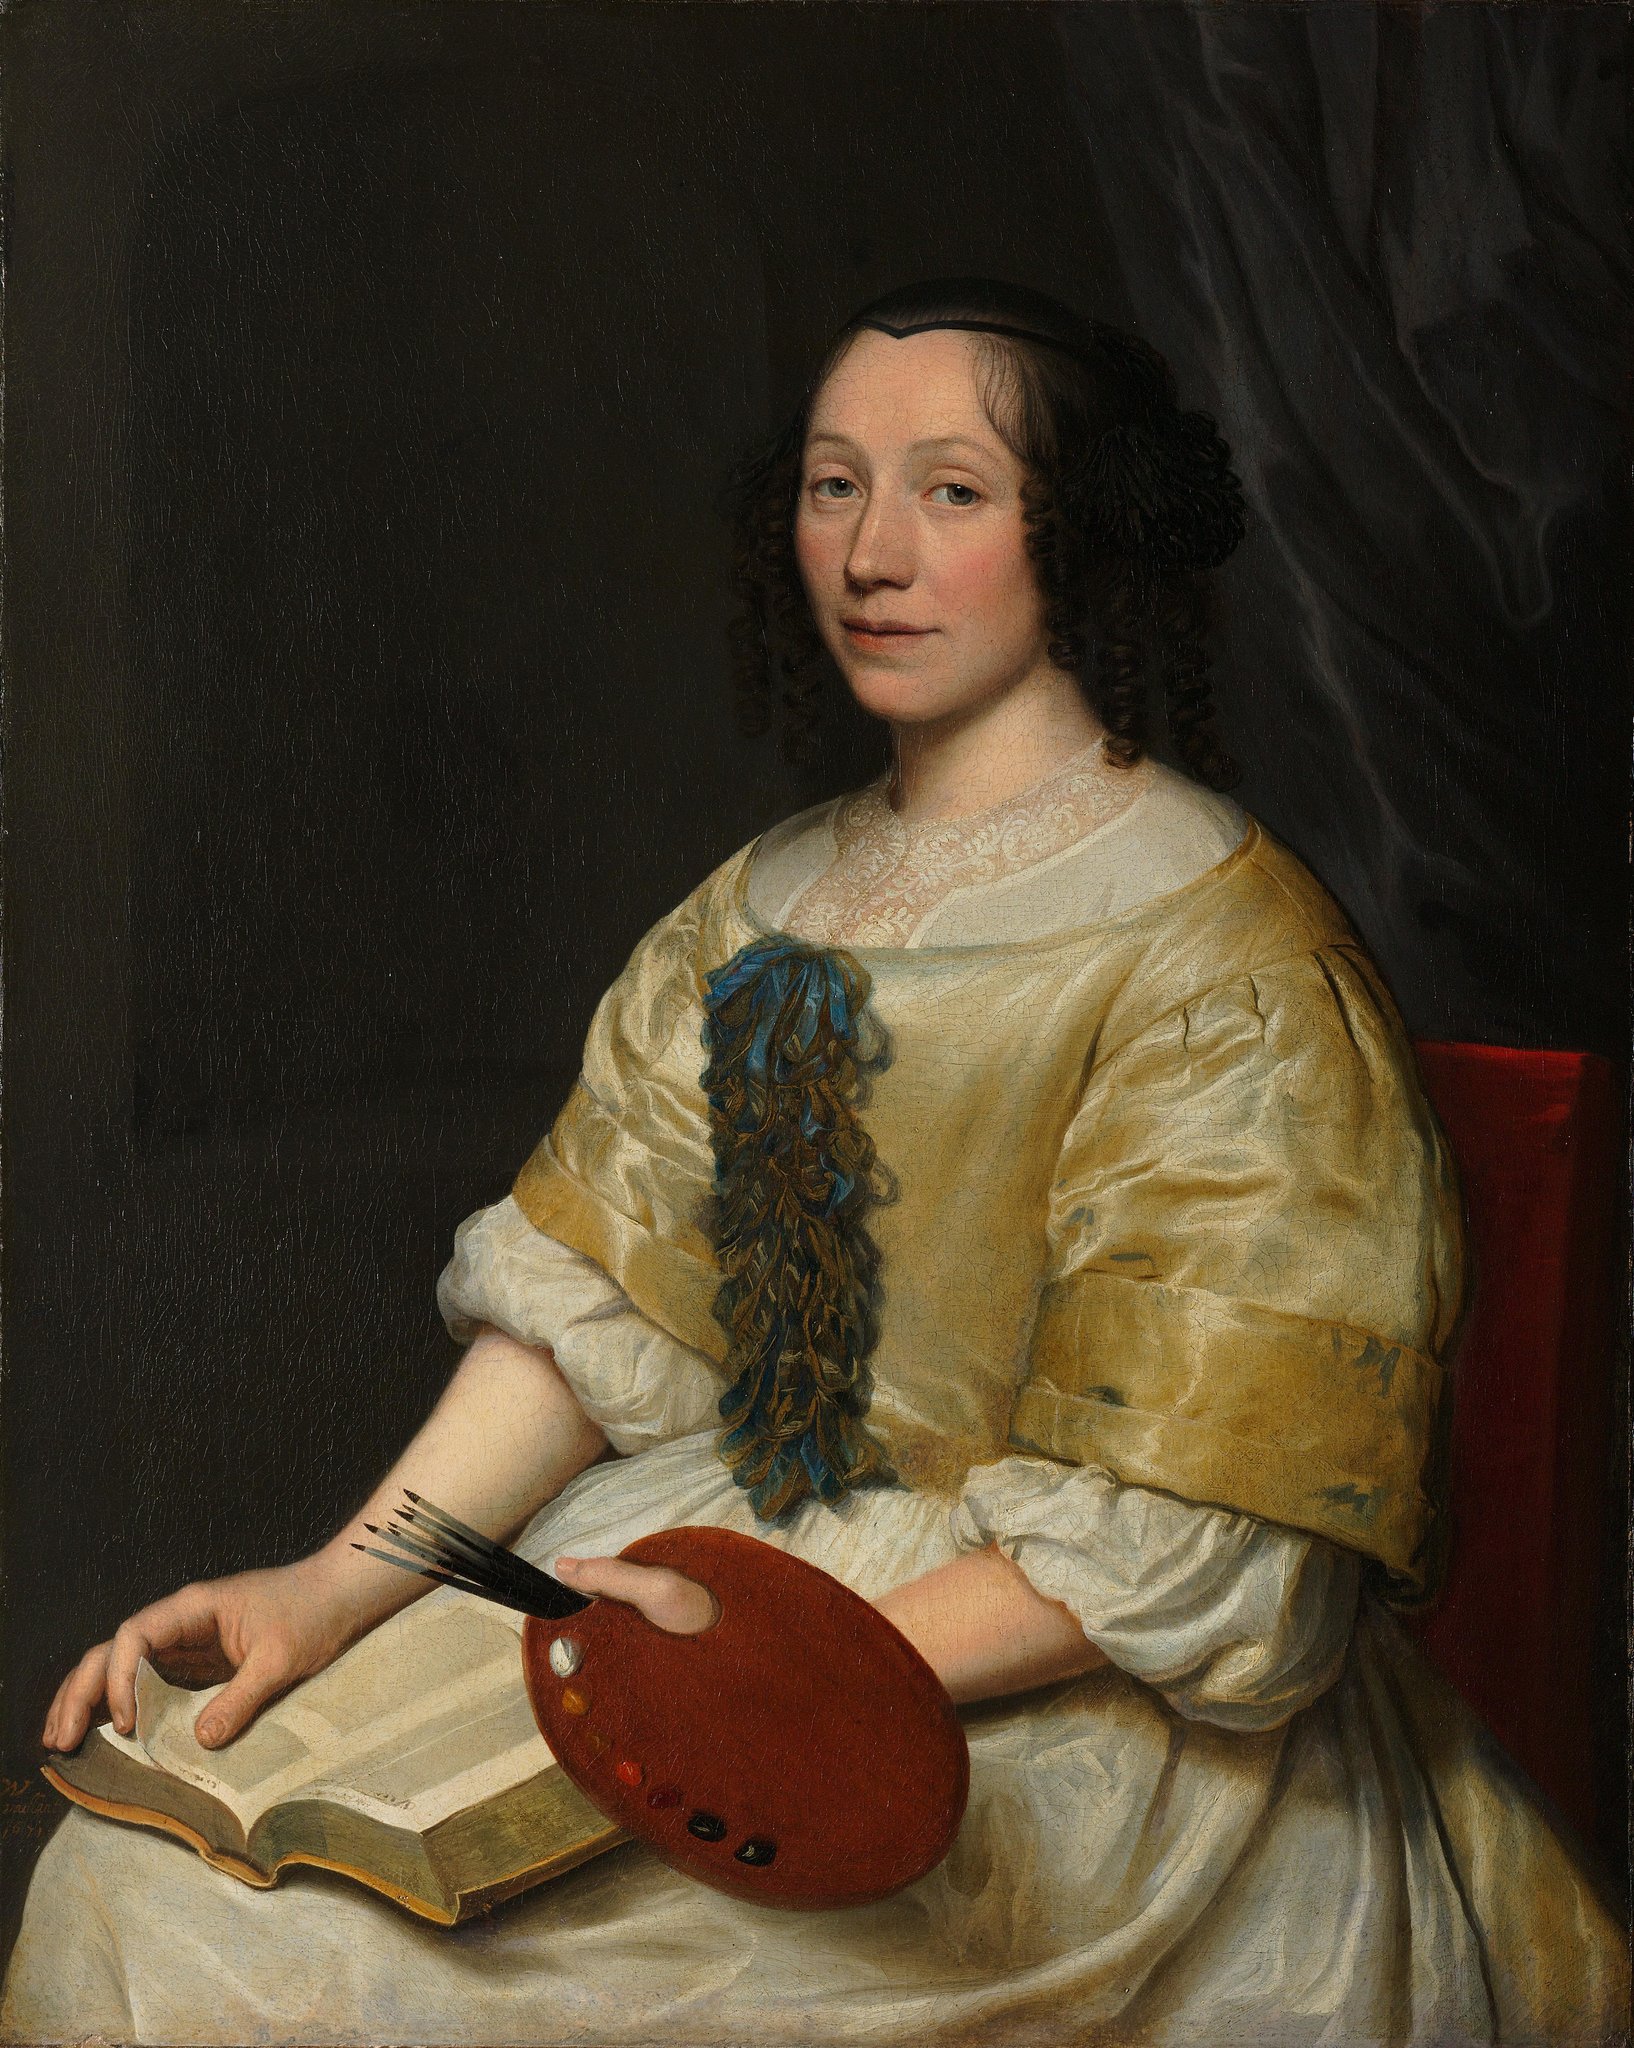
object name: painting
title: Portrait of Maria van Oosterwijck (1630-1693)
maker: wallerant vaillant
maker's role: draughtsman, painter, print maker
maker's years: 1623-1677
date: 1671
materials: canvas, oil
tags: painter, historical persons - bb - woman, portrait, self-portrait of painter, portrait, self-portrait of artist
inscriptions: signature and date, bottom left: ‘W vaillant 1671’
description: Maria van Oosterwijck is portrayed here as a pious and accomplished artist. The palette and brushes allude to her profession, while the Bible symbolizes her virtue and piety. Van Oosterwijck’s flower still lifes garnered her fame at home and abroad. Her work could be found in the art collections of Emperor Leopold I, Louis XIV, and the English royal couple William III and Mary Stuart.